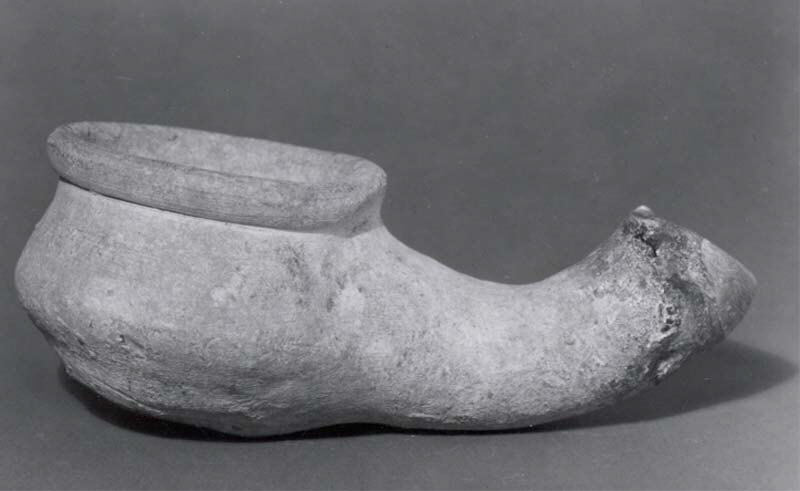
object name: lamp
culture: assyrian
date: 800-601 BCE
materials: ceramic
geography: mesopotamia